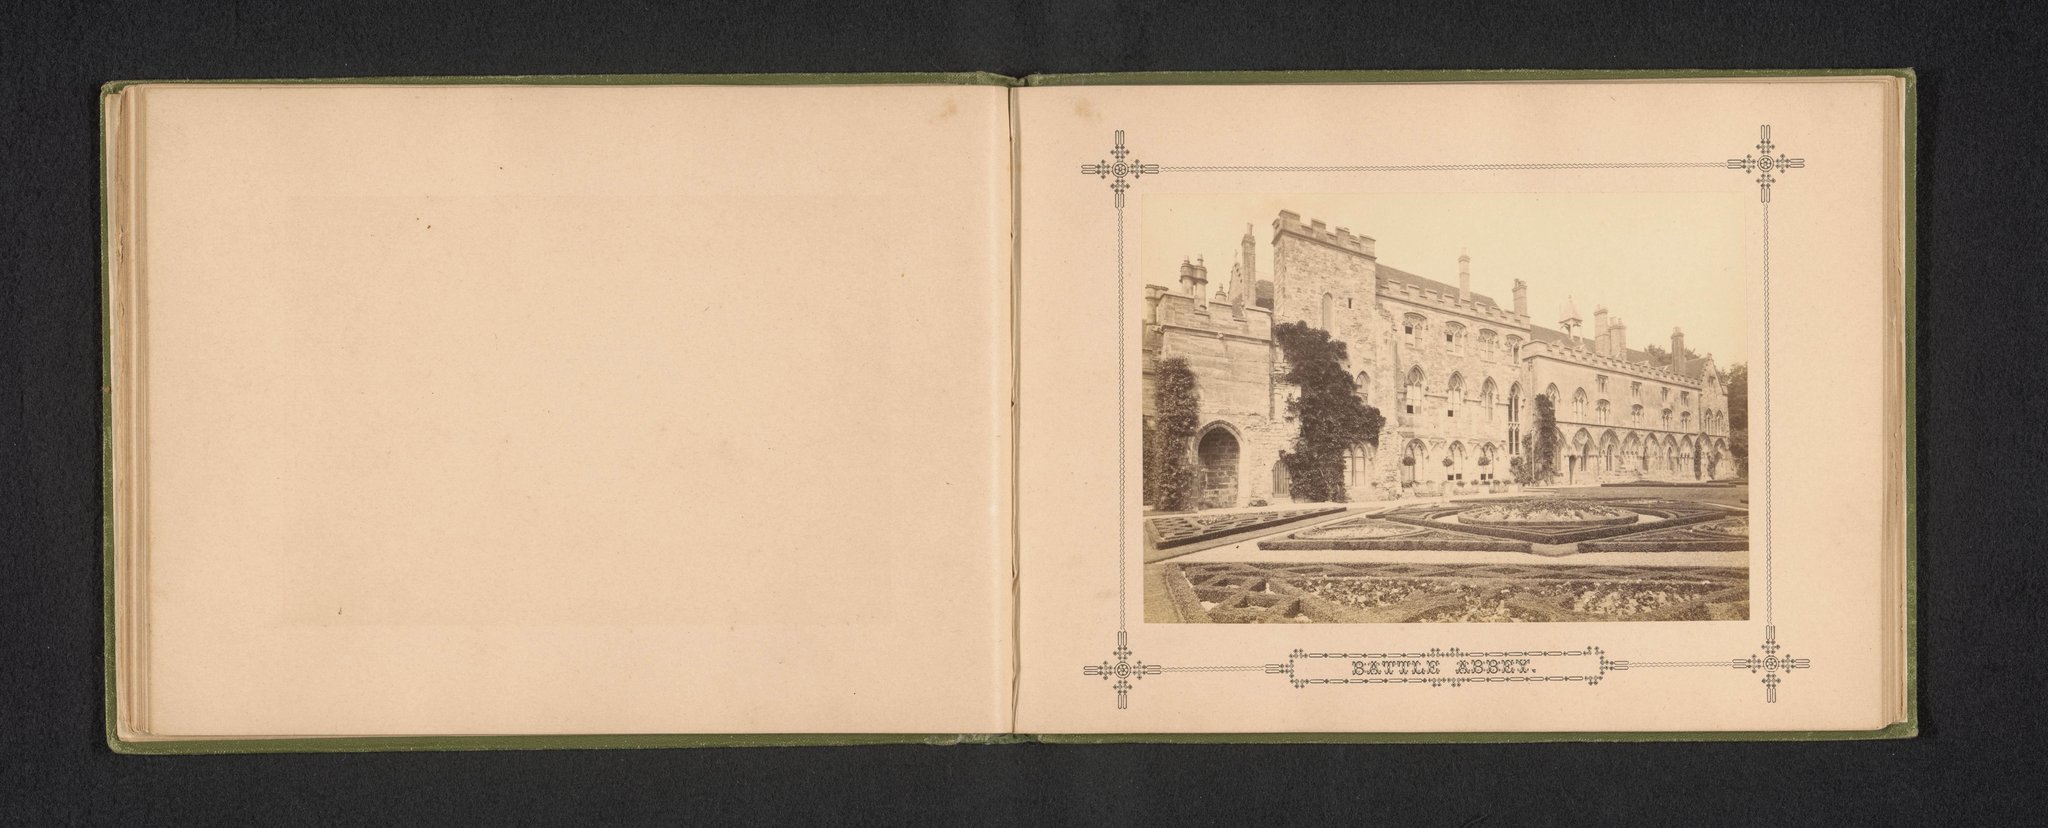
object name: page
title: Gezicht op Battle Abbey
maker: wm. e. thorpe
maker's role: fotograaf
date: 1870-1875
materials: photographic support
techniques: albumen print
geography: battle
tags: abbey, monastery, convent ~ roman catholic church